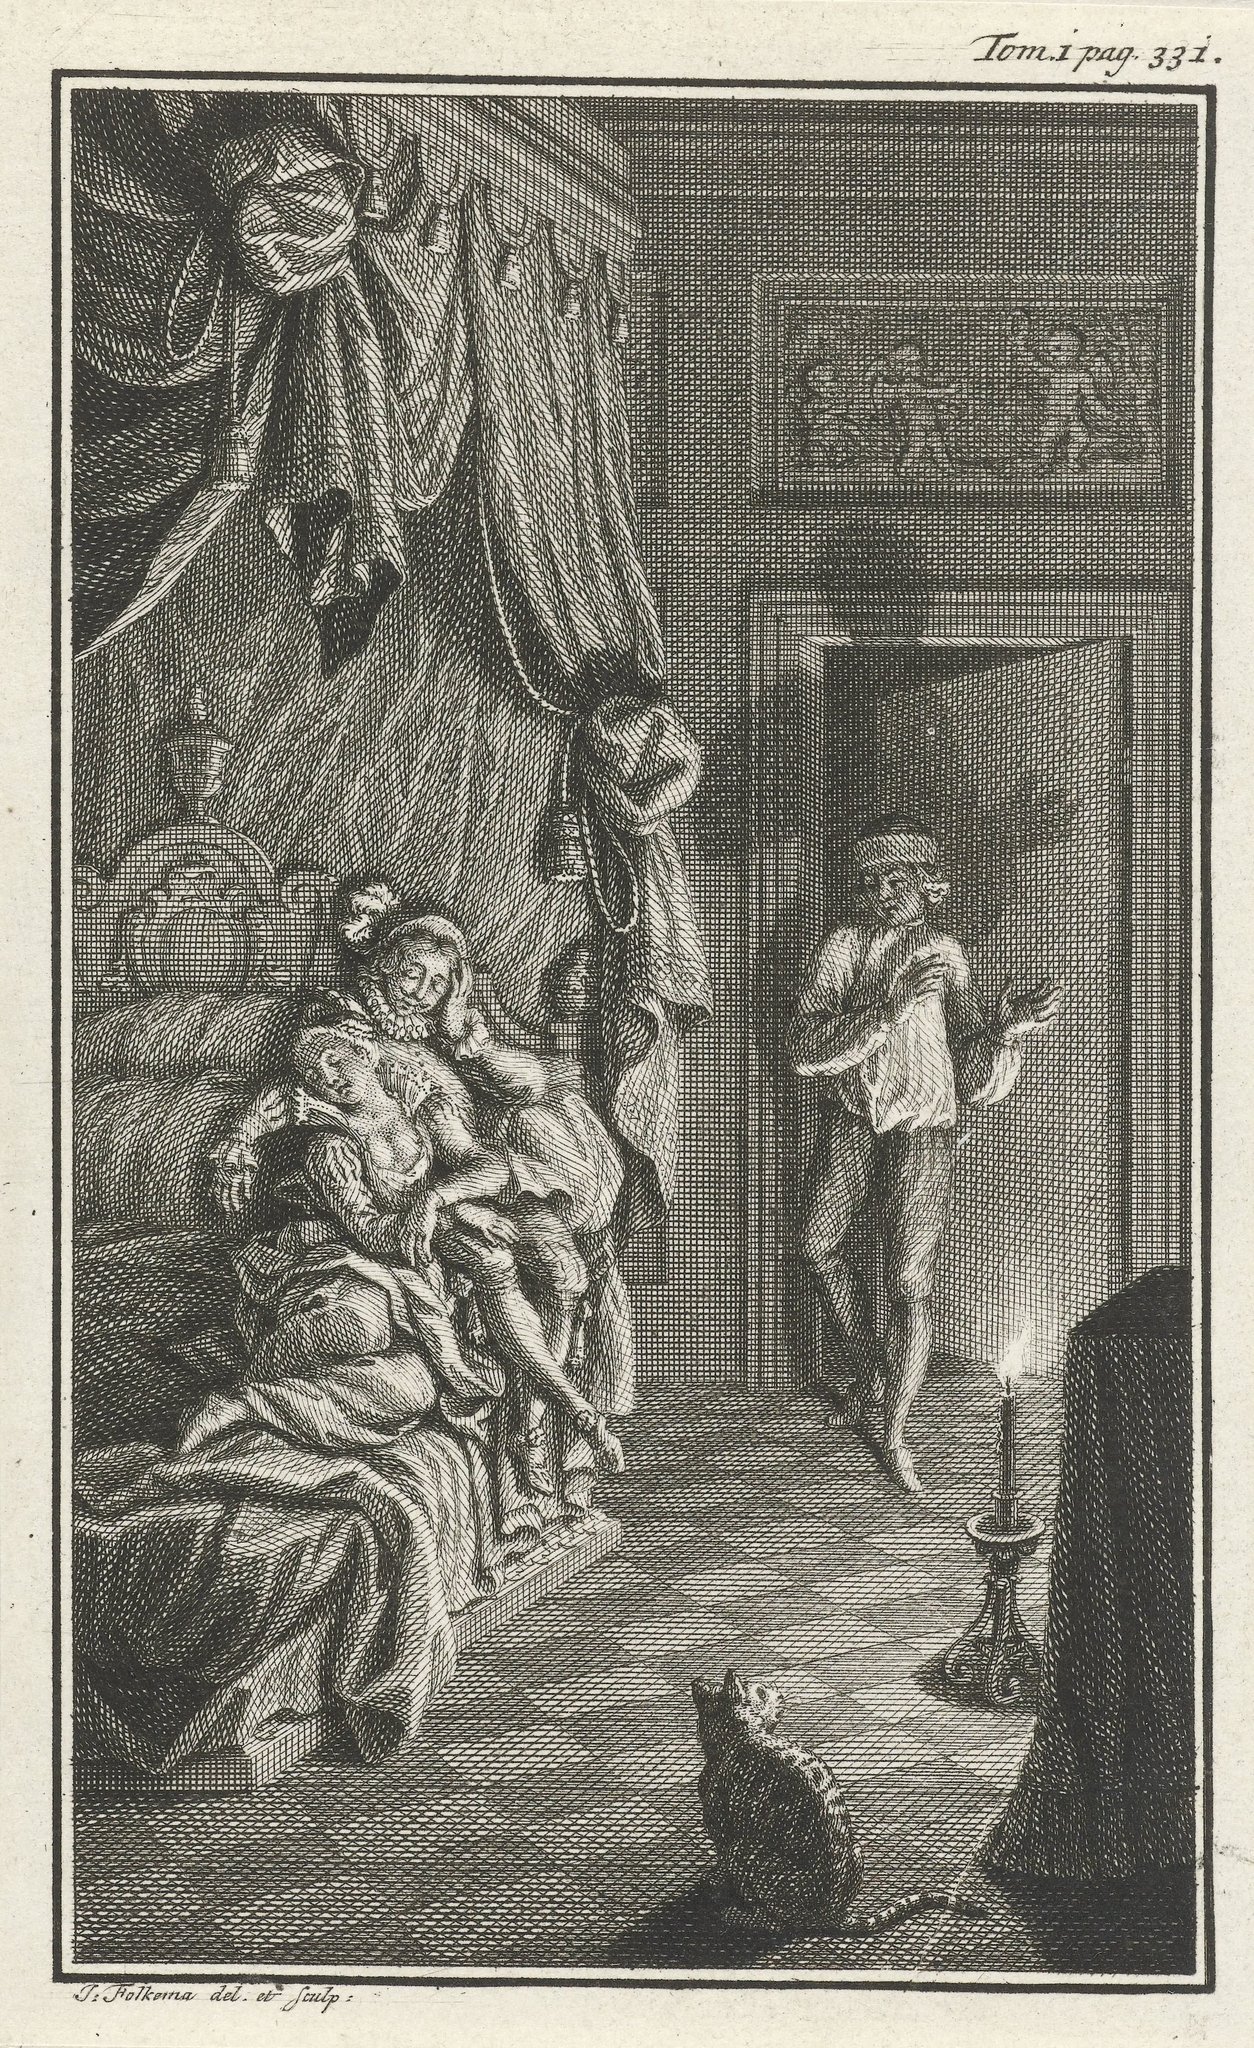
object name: book illustration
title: Man betrapt zijn echtgenote met minnaar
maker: jacob folkema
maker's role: draughtsman, print maker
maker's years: 1692-1767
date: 1702-1767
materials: paper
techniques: etching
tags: lovers' meeting, bedroom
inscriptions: collector's mark: Lugt 240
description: Een man in slaapkleding loopt een schaars verlichte slaapkamer binnen. Geschrokken kijkt hij naar een man en vrouw die op bed tegen elkaar geleund in slaap zijn gedommeld. Prent rechtsboven gemerkt: Tom 1 pag. 331.